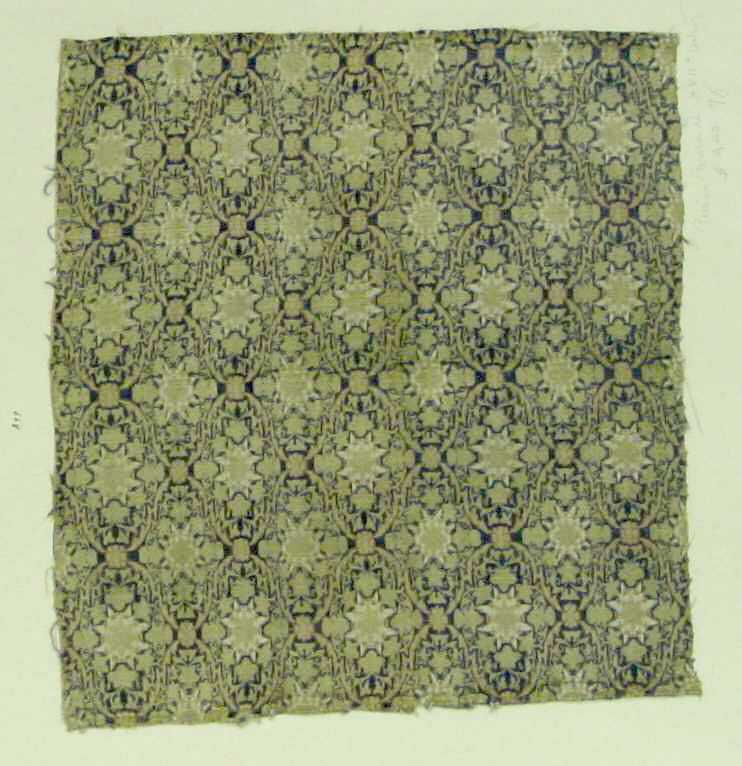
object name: textile fragment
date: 1601-1700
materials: metal thread, silk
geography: iran